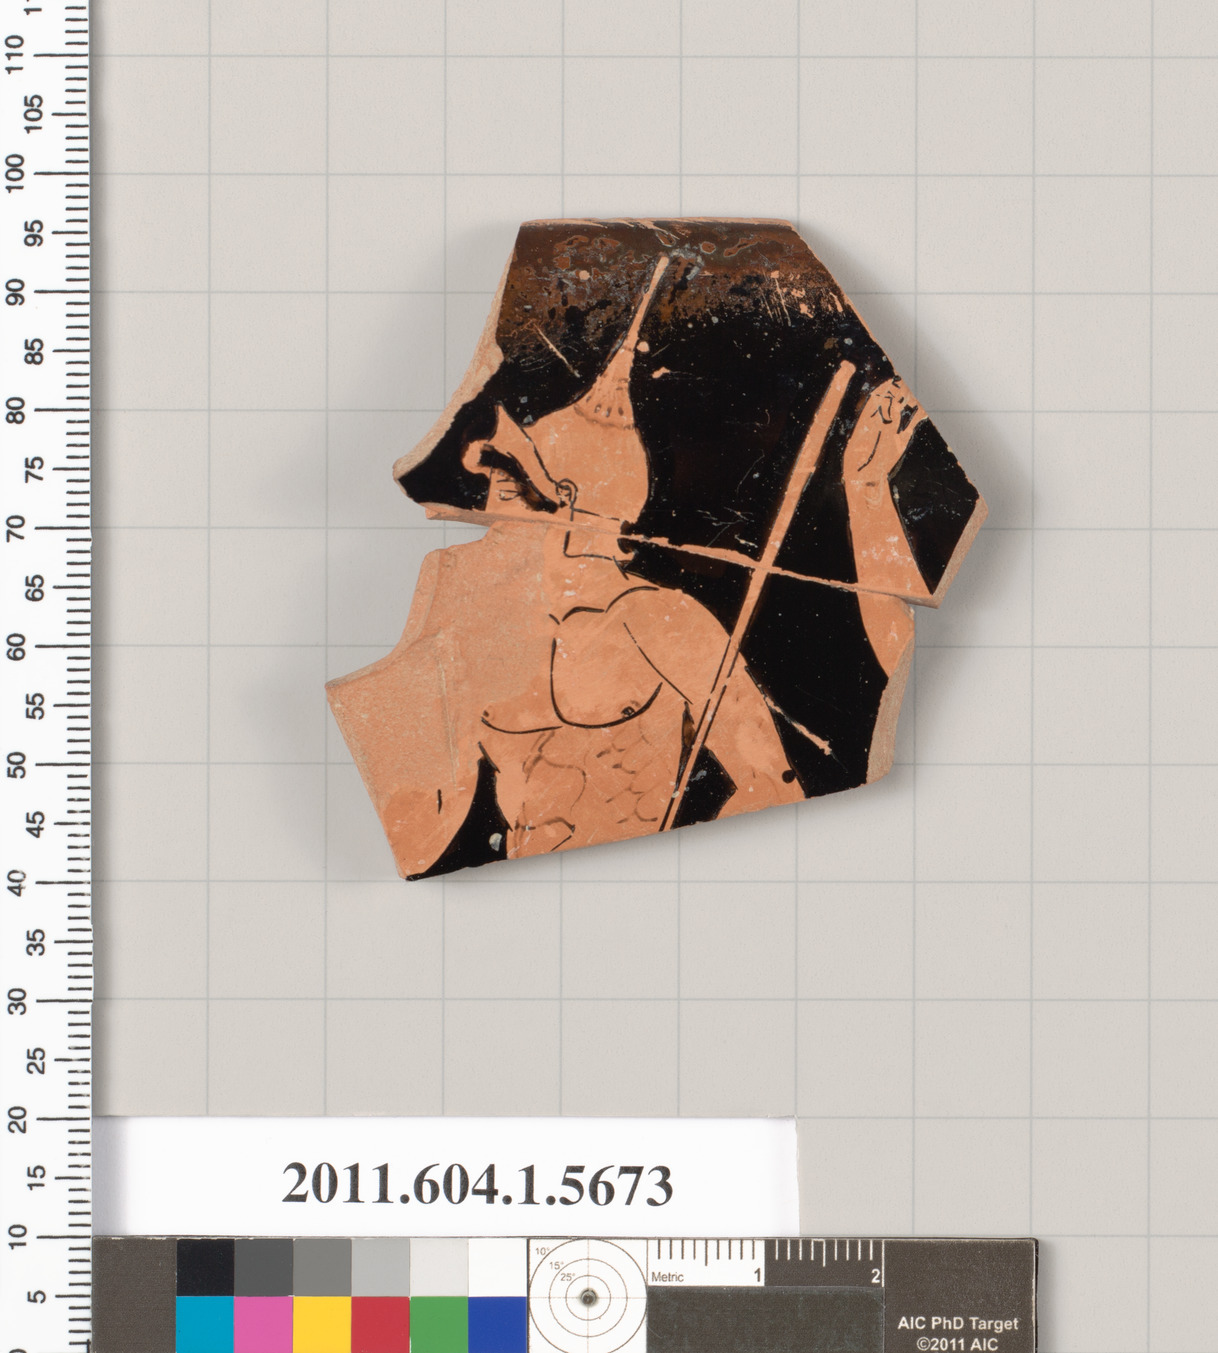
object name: kylix fragment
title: Terracotta rim fragment of a kylix (drinking cup)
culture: greek, attic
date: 475-451 BCE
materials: terracotta